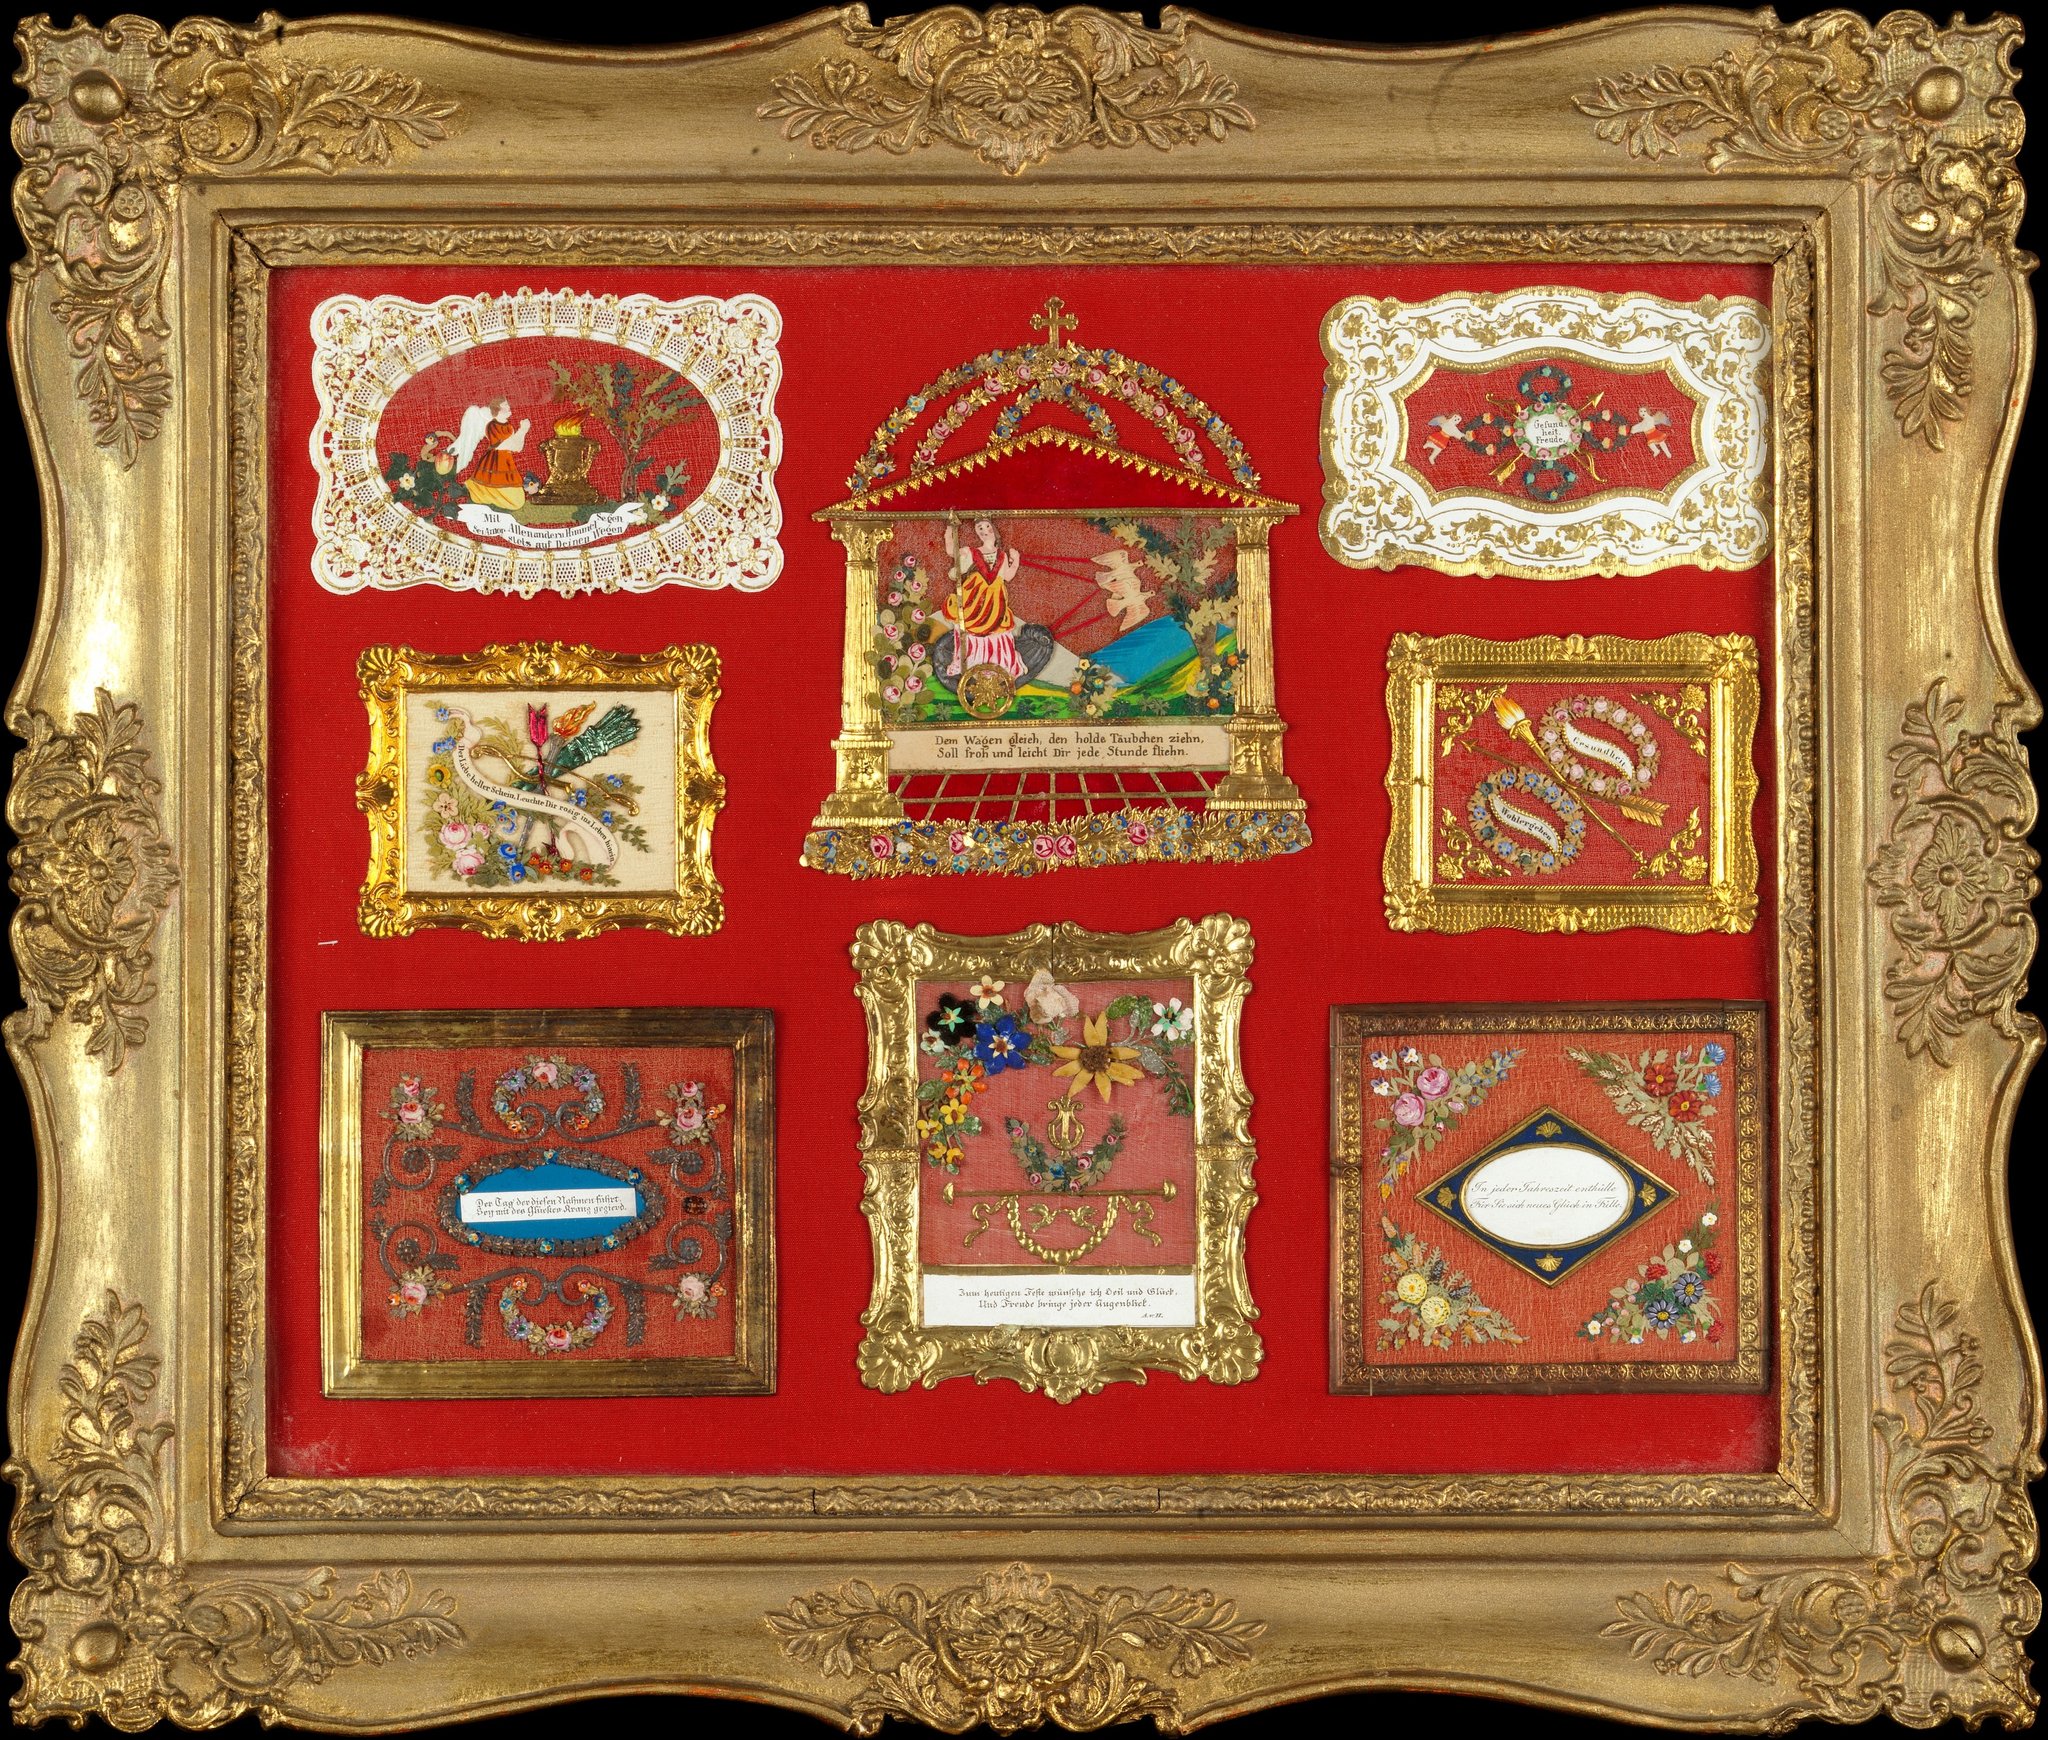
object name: cut paper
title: Eight Kunstbillets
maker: anonymous, austrian, viennese, 19th century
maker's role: artist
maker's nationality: austrian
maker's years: 1800-1900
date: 1801-1900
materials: textile, gouache, paper, silk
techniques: cutting, embossing, gilding, printing